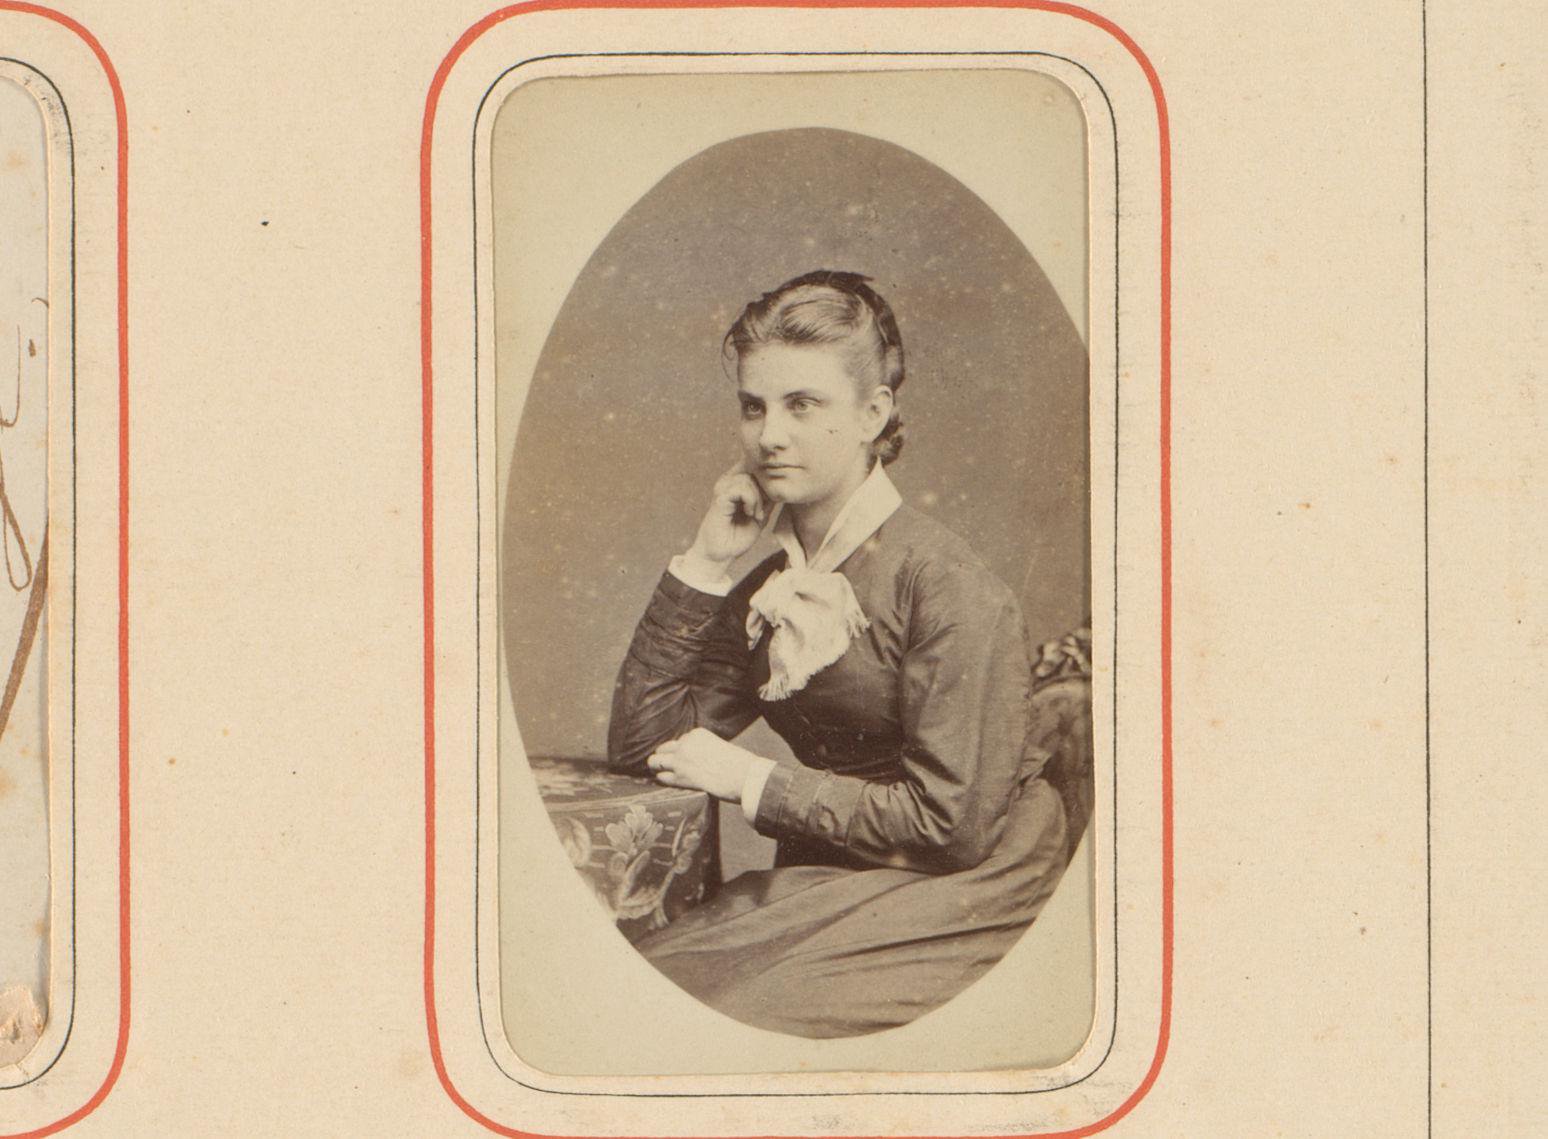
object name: album leaf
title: Portret van een onbekende vrouw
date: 1870-1890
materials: cardboard, paper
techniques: albumen print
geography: batavia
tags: anonymous historical person portrayed - bb - woman